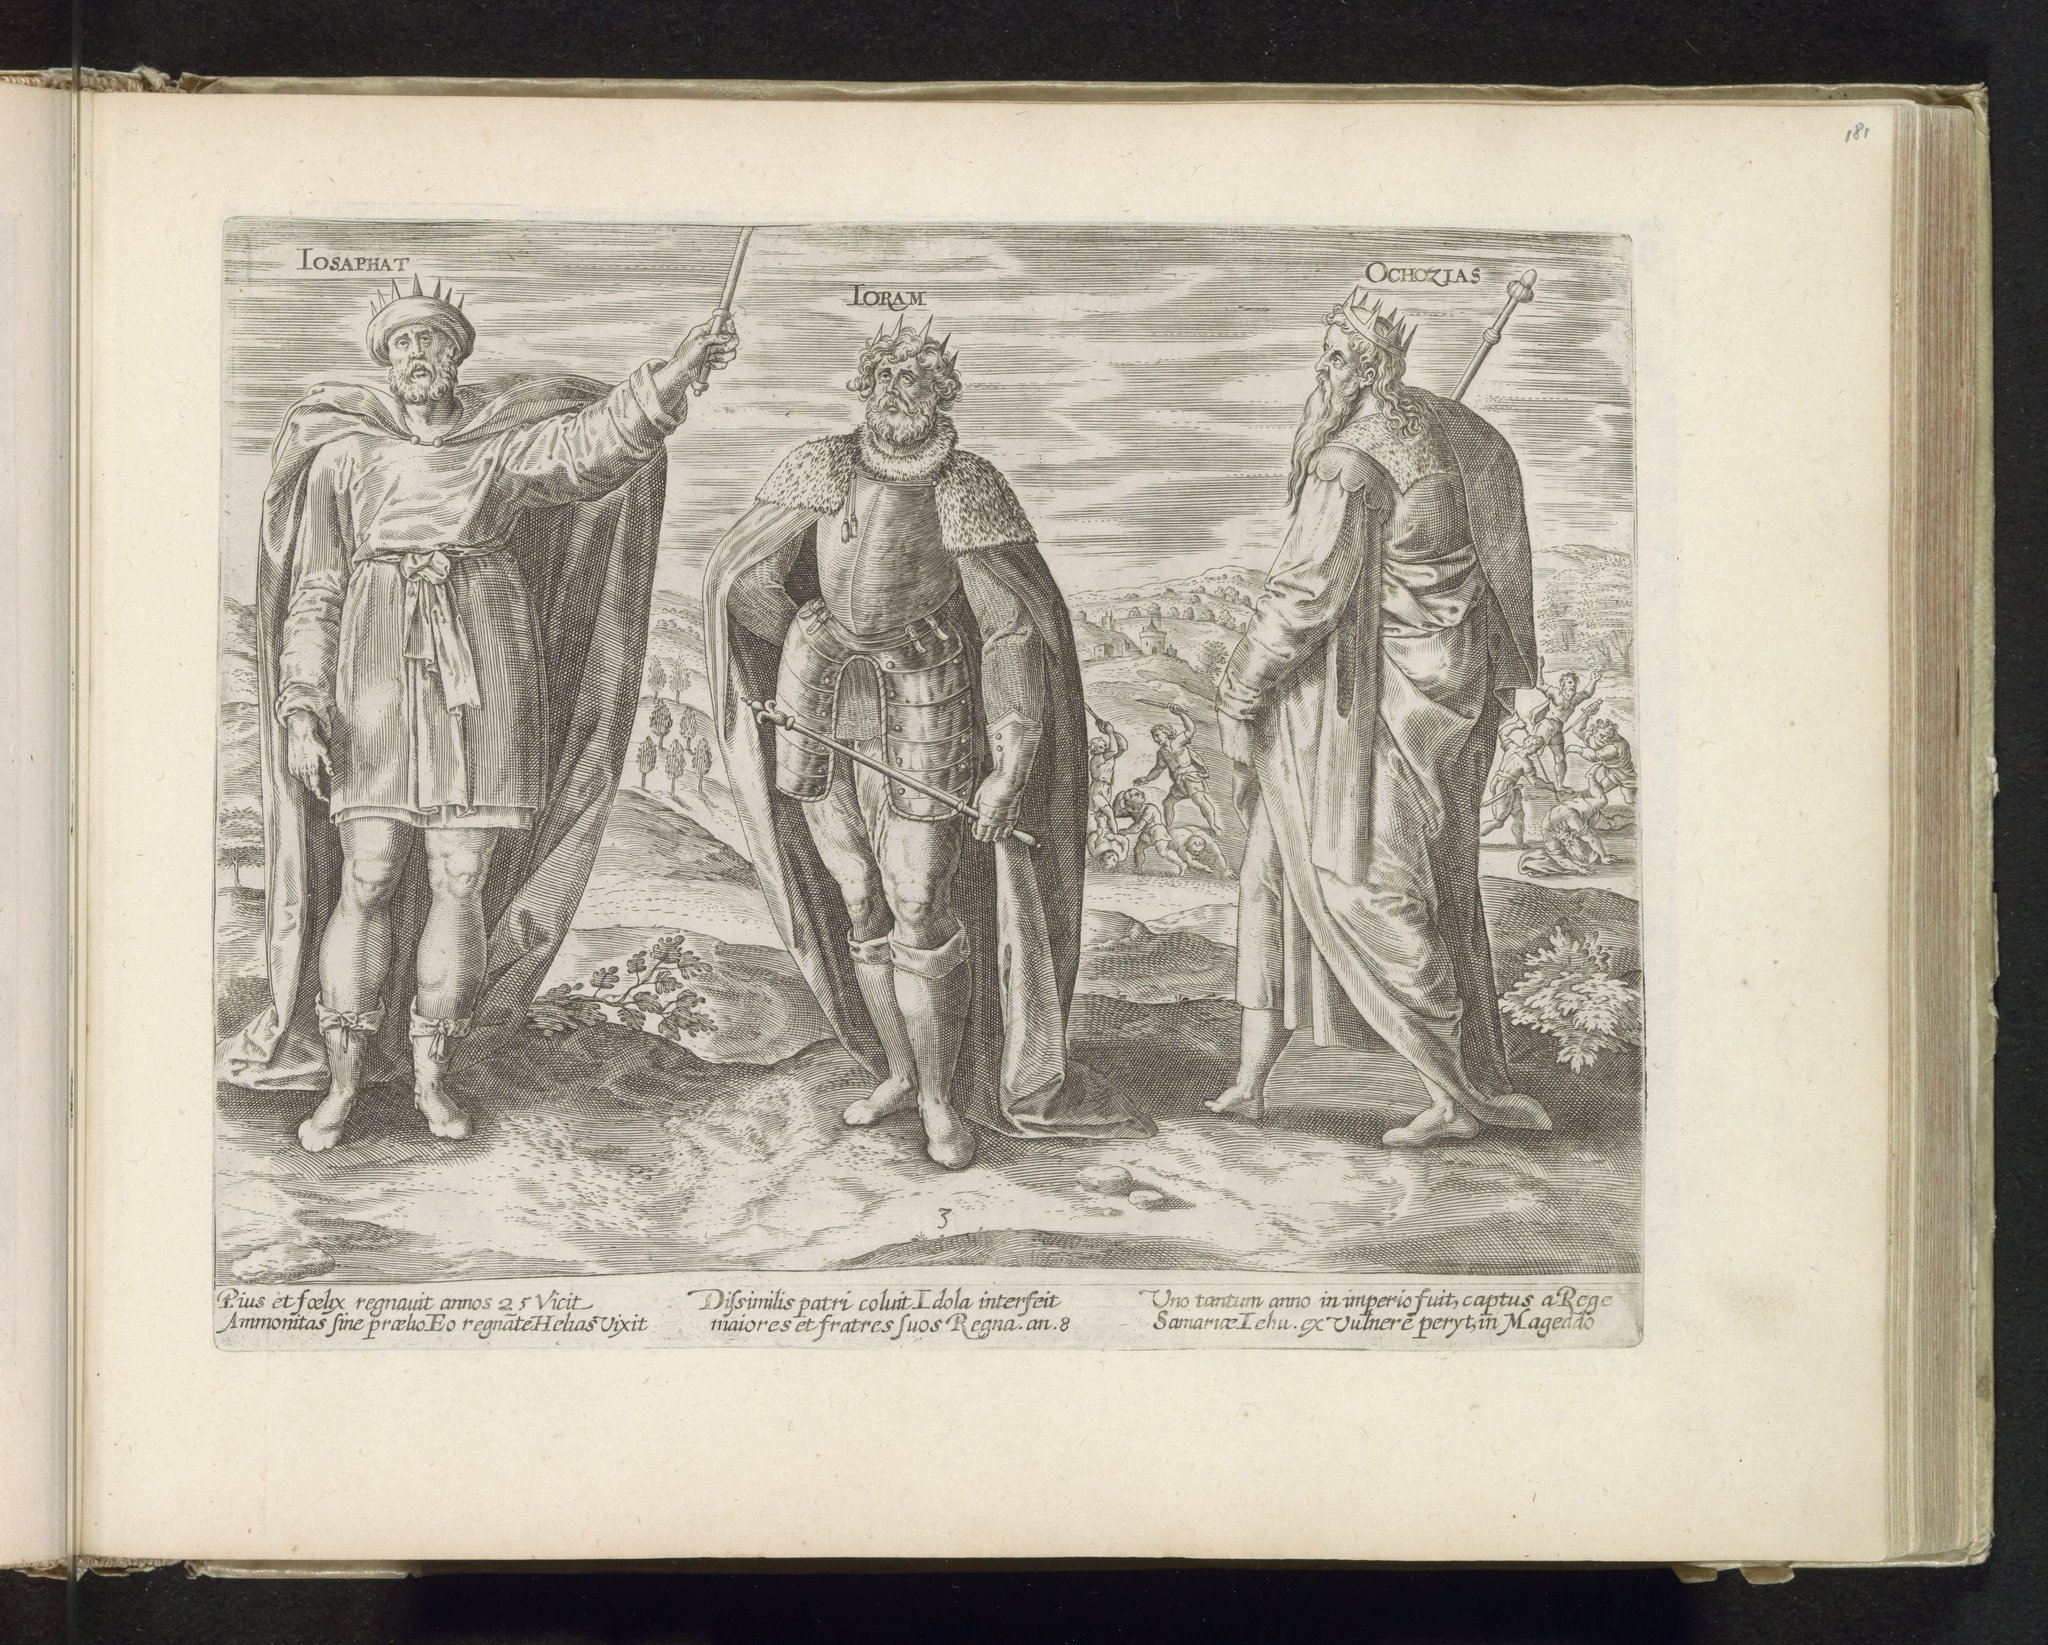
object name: album leaf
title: Thesaurus sacrarum historiaru[m] veteris testame[n]ti, elega[n]tissimis imaginibus expressu[m] excelle[n]tissimoru[m] in hac arte viroru[m] opera: nu[n]c primu[m] in luce[m] editus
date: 1585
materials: paper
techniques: engraving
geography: antwerp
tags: death of ahaziah, story of ahaziah (ochozias), son of jehoram, king of judah (2 kings 8:25-29; 2 chronicles 22:1-9), story of jehoram (joram), son of jehoshaphat, king of judah (2 kings 8:16-24; 2 chronicles 21), story of jehoshaphat (josaphat), son of asa, king of judah (1 kings 22:41-51; 2 chronicles 17-20), kings of israel and judah ~ the old testament (not in biblical context)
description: De koningen Josefat, Joram en Achazja. Op de achtergrond enkele belangrijke gebeurtenissen uit hun leven. Midden op de achtergrond slaan twee mannen met stokken drie kinderen. Rechts op de achtergrond de dood van Achazja. Onder de voorstelling toelichtingen in het Latijn. Deze prent maakt deel uit van een album.